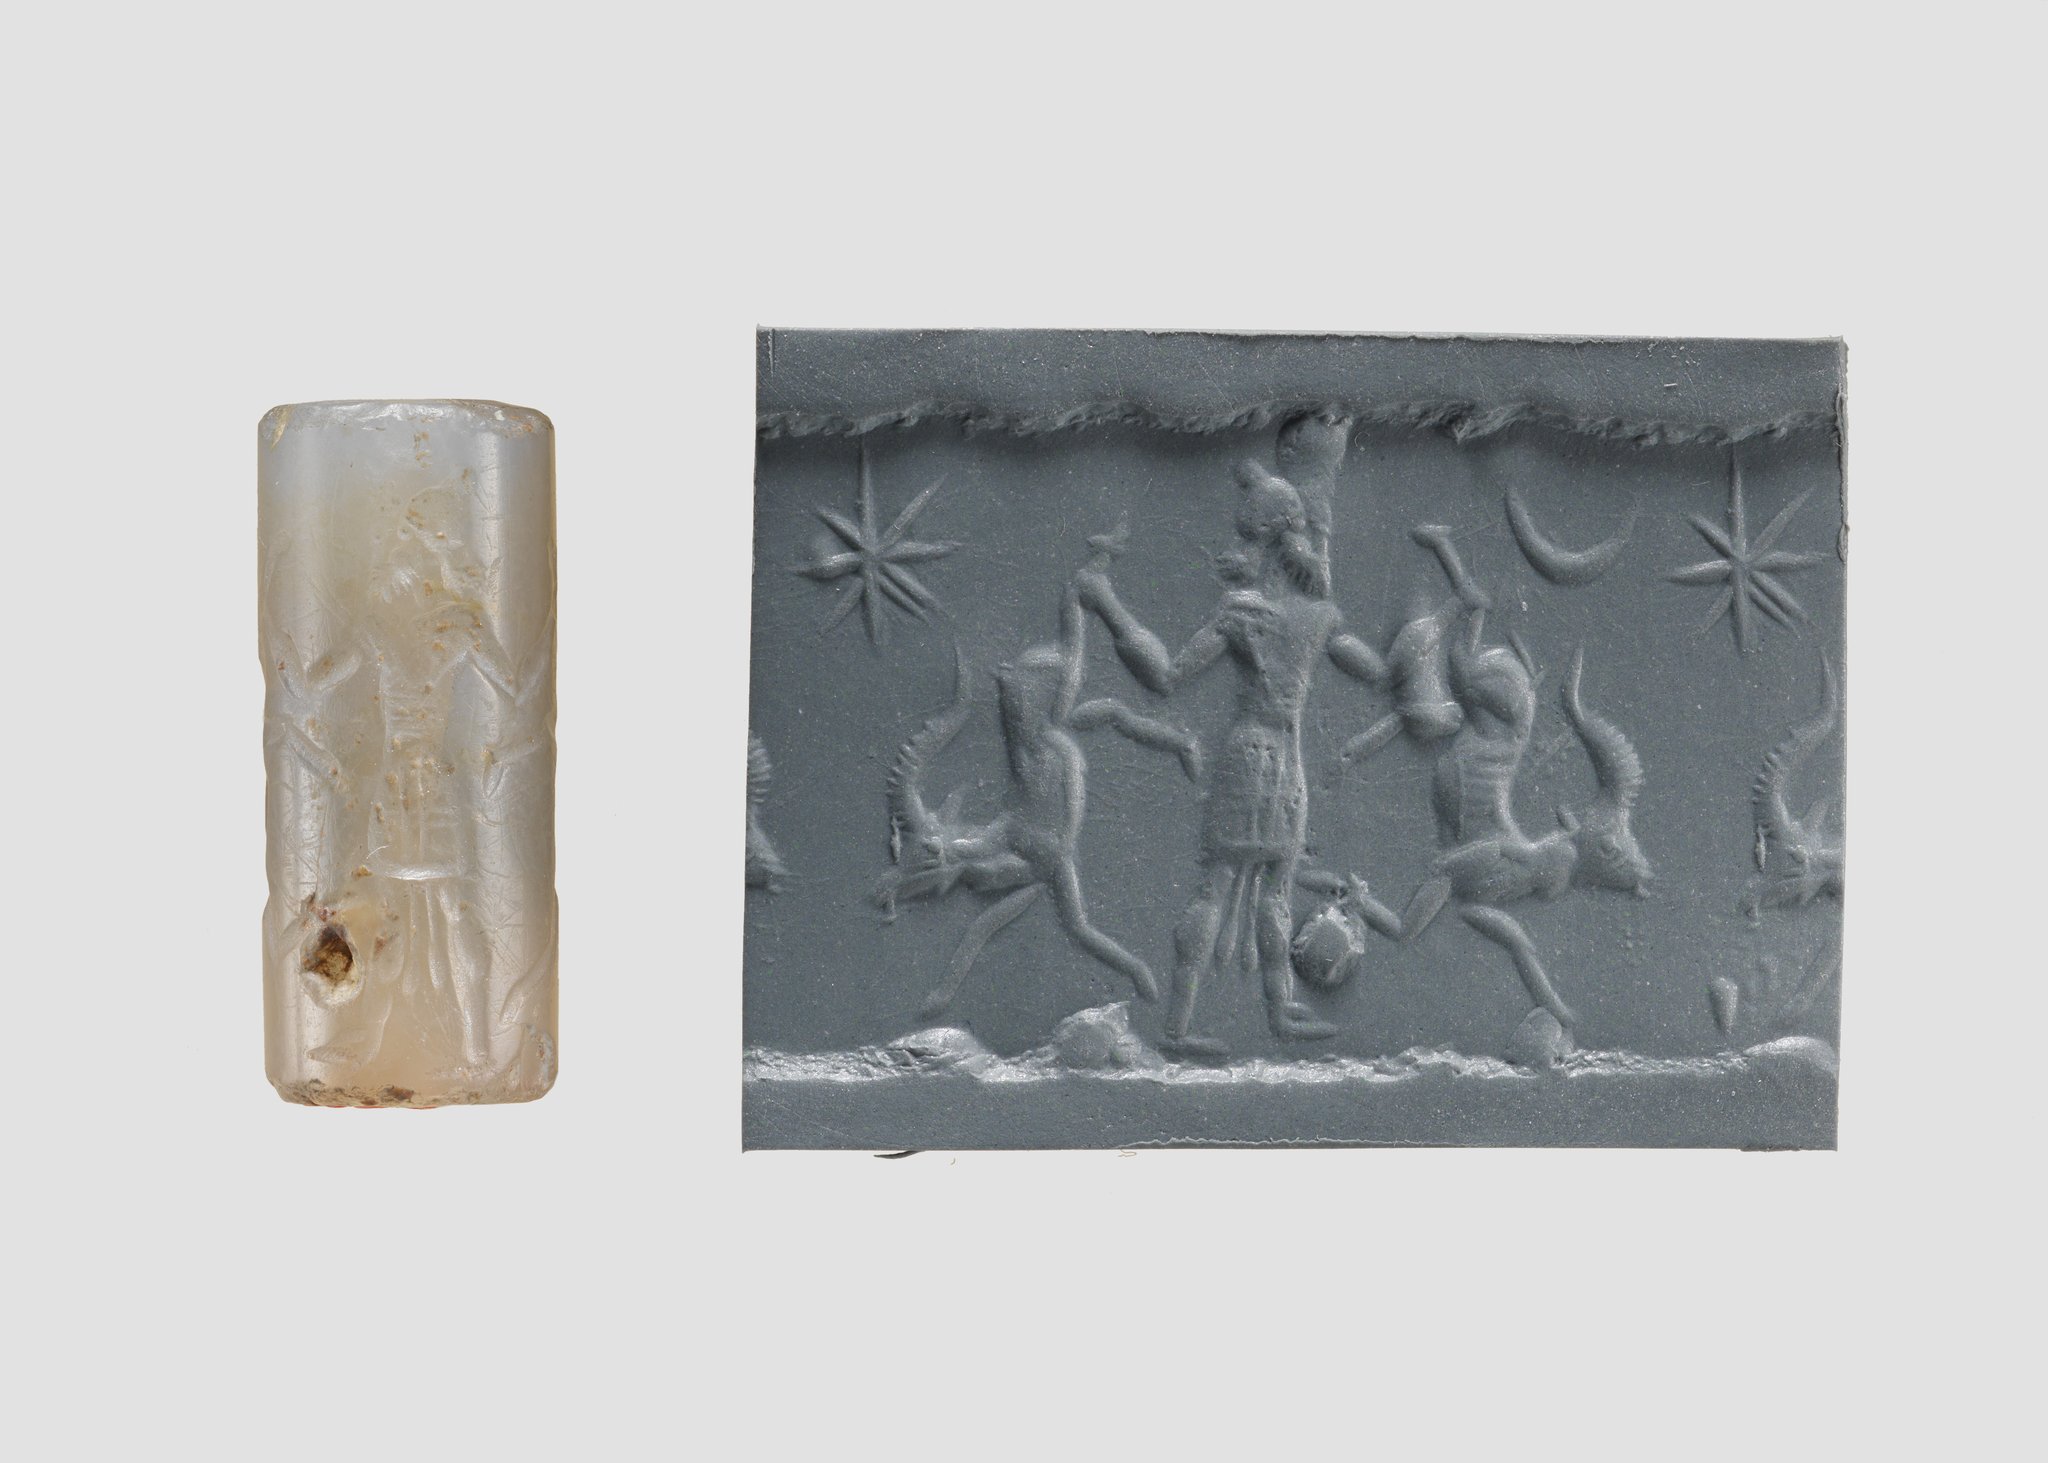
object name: cylinder seal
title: Cylinder seal and modern impression: hero grasping two antelopes by their hind legs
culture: assyrian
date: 1300-1201 BCE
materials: stone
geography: iran, luristan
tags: animals,men